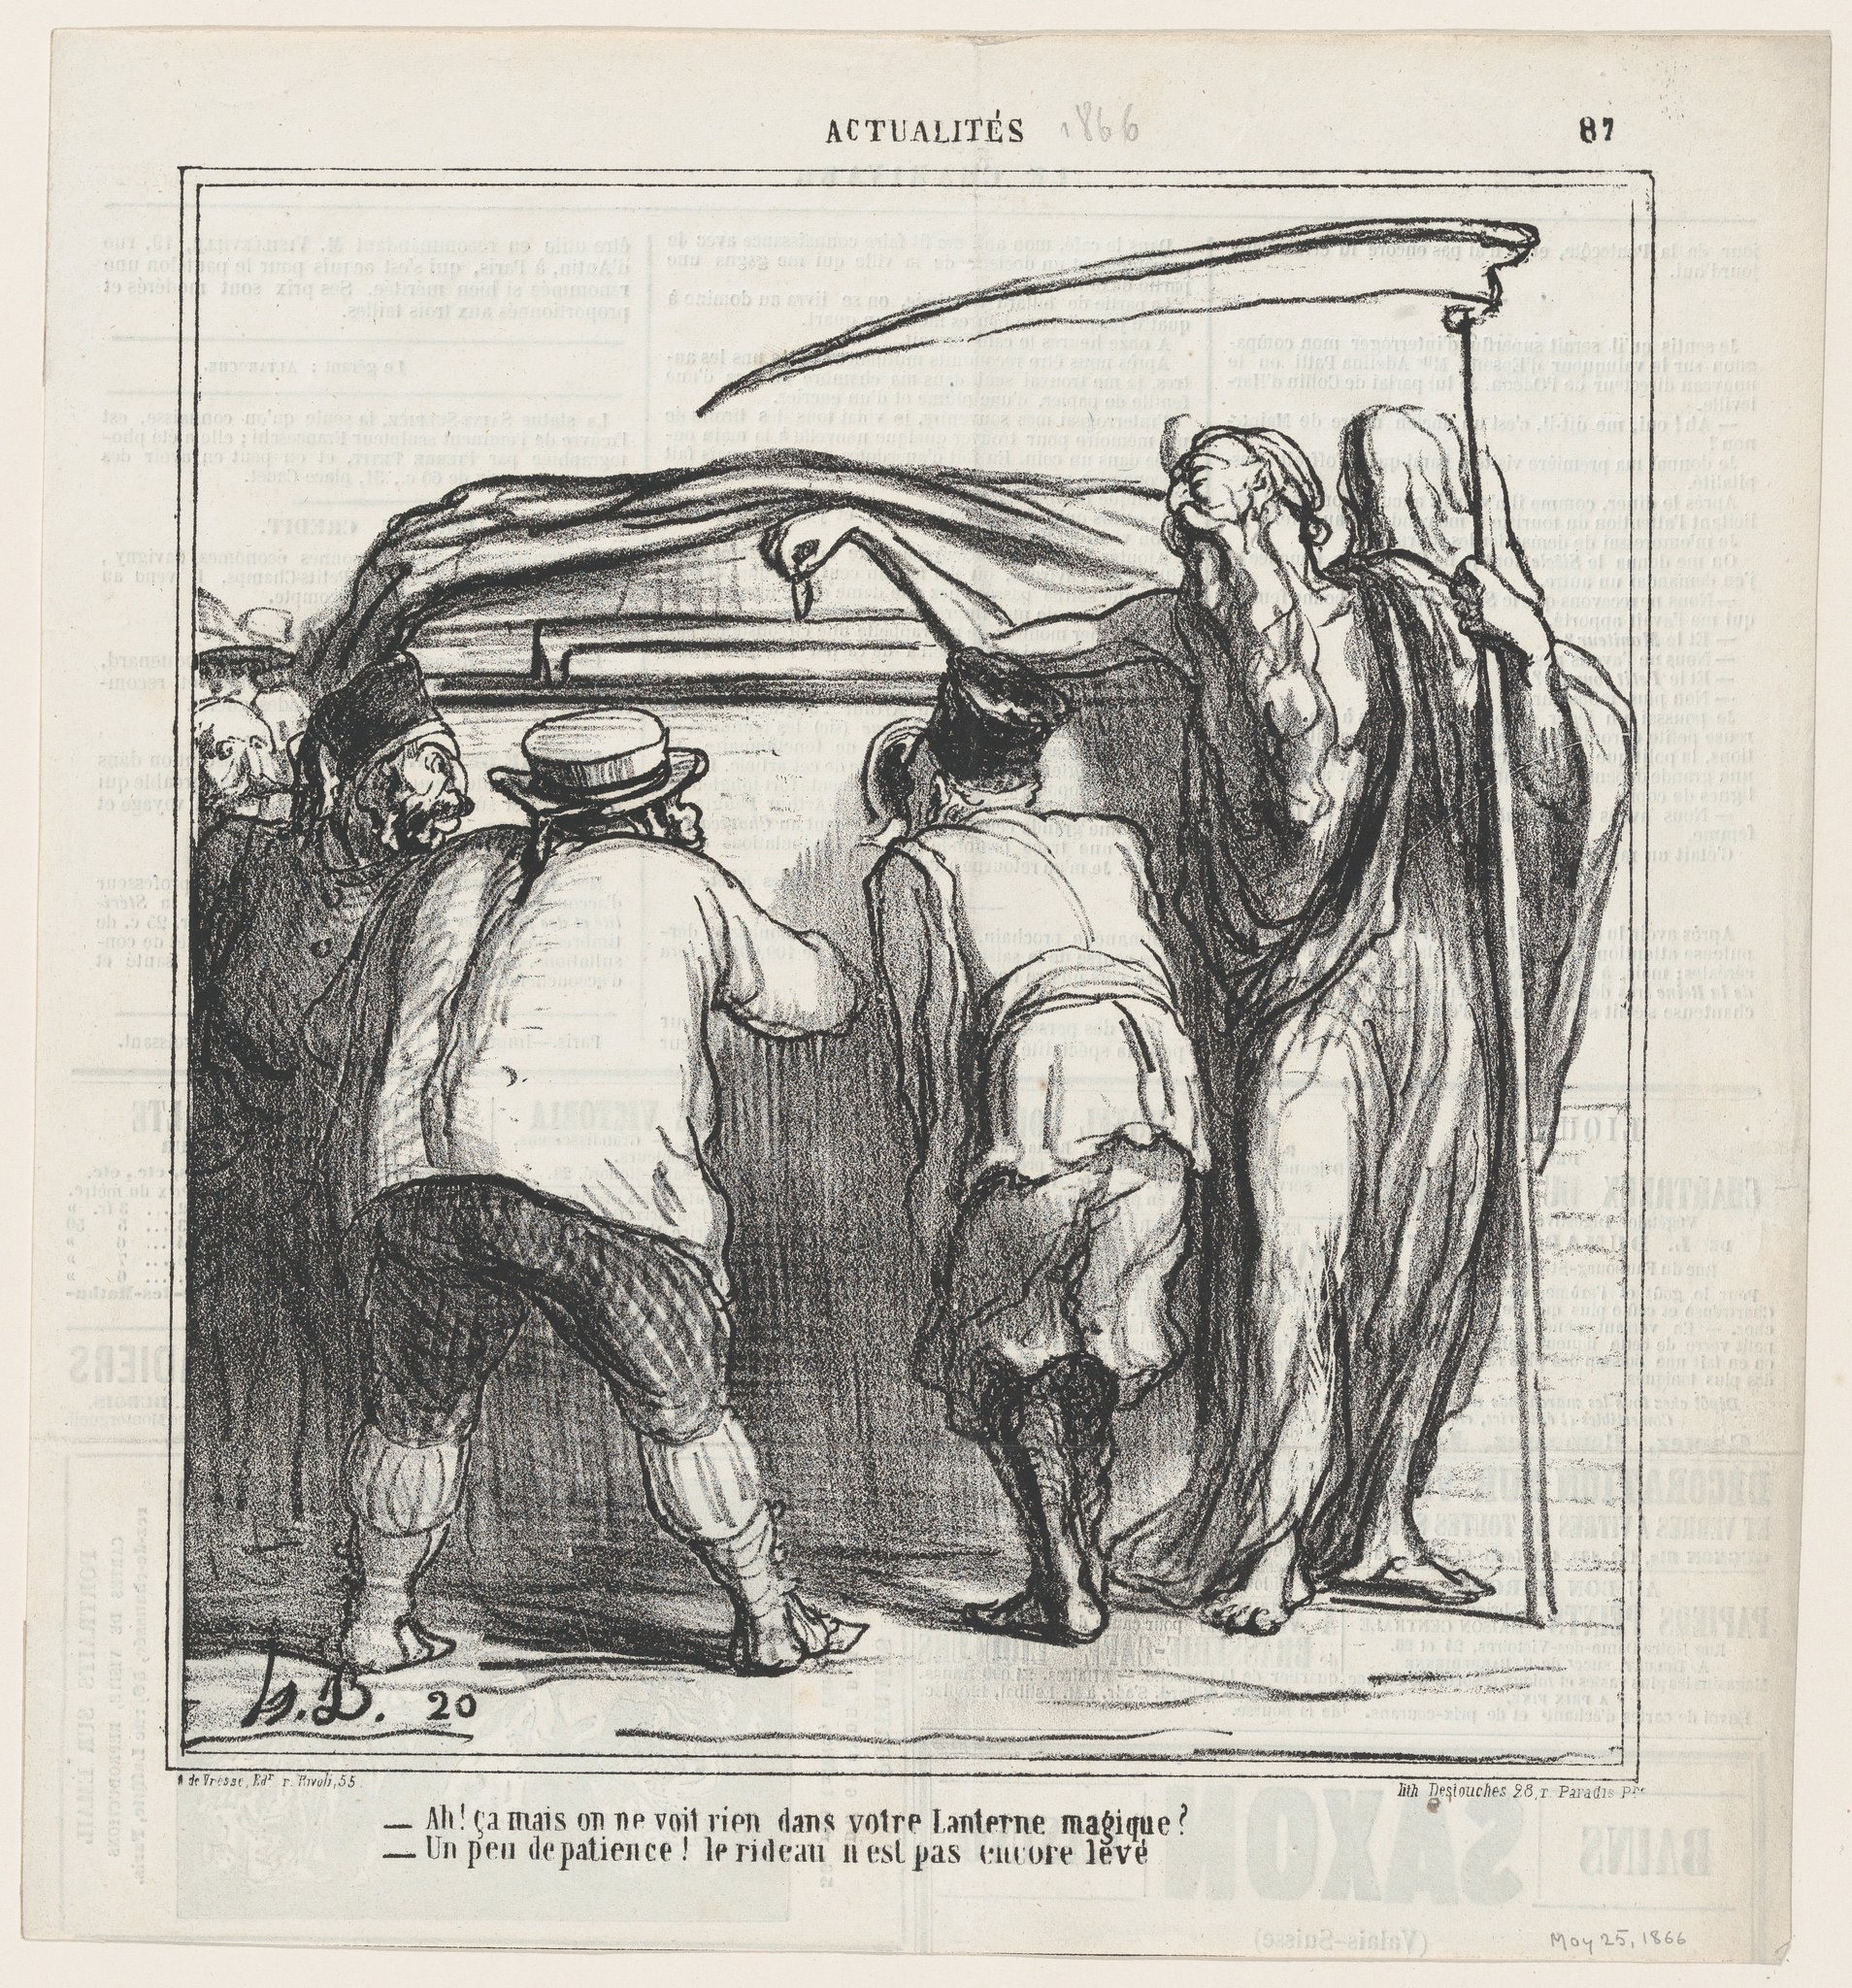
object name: print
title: –But look, I don't see a thing in your magic lantern! –Just be a bit more patient... the curtain isn't up yet., from 'News of the day,' published in Le Charivari, May 25, 1866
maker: honoré daumier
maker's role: artist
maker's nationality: french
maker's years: 1808-1879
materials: paper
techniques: lithograph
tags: men